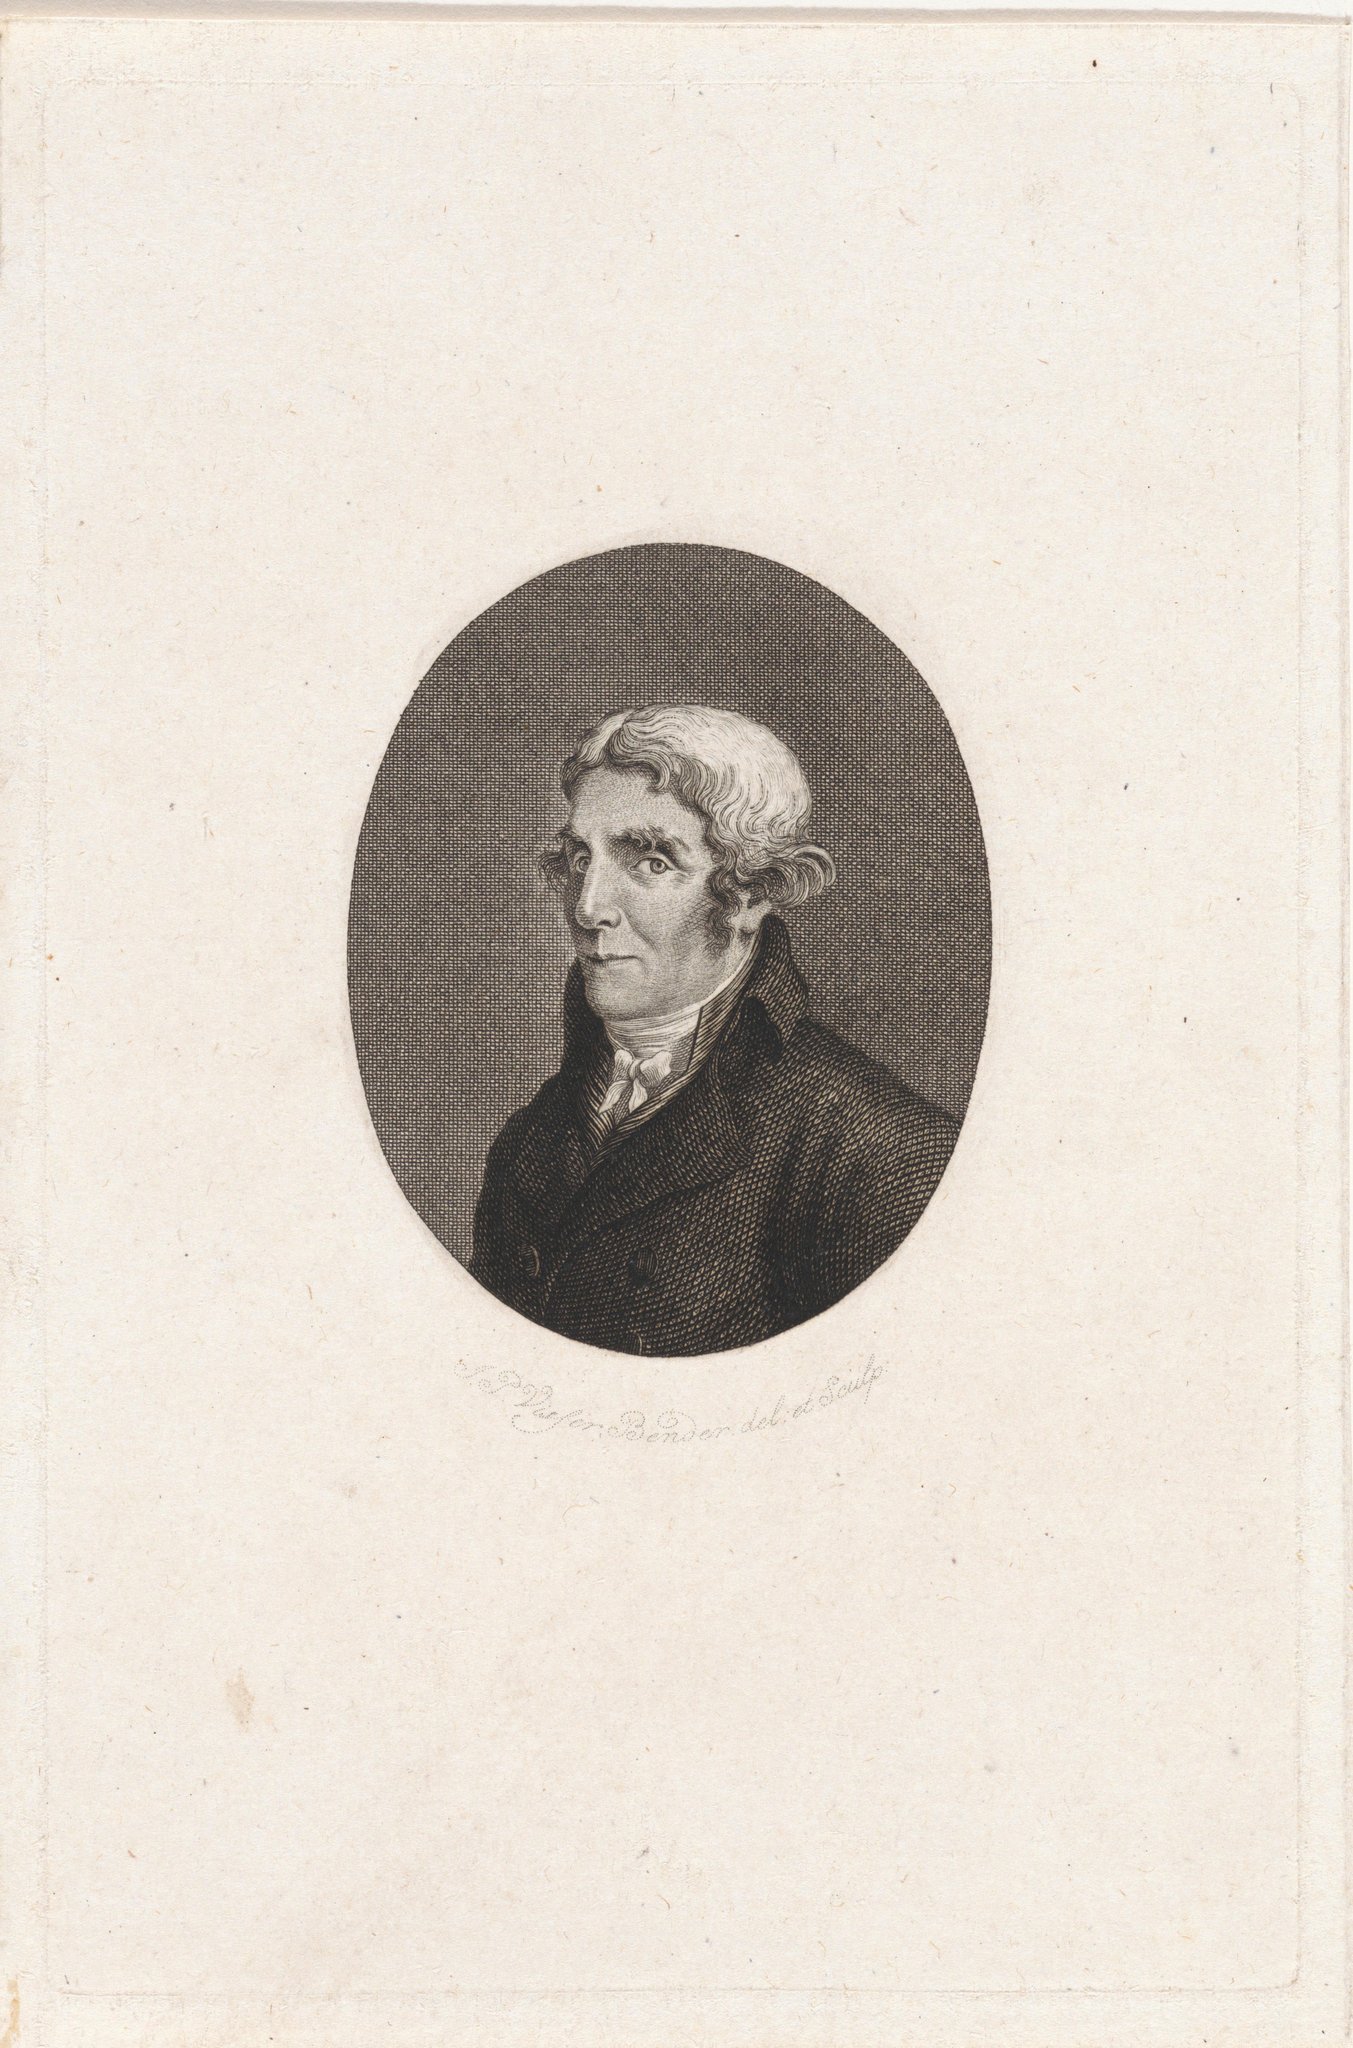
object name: print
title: Portret van Izaak Jansz. de Wit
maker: joannes pieter visser bender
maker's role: draughtsman, print maker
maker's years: 1785-1813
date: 1809-1813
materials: paper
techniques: engraving, etching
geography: haarlem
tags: amsterdam, print maker, draughtsman, publisher, izaak jansz. de wit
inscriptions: collector's mark: Lugt 2228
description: Portret van de Nederlandse prentmaker Izaak Jansz. de Wit.